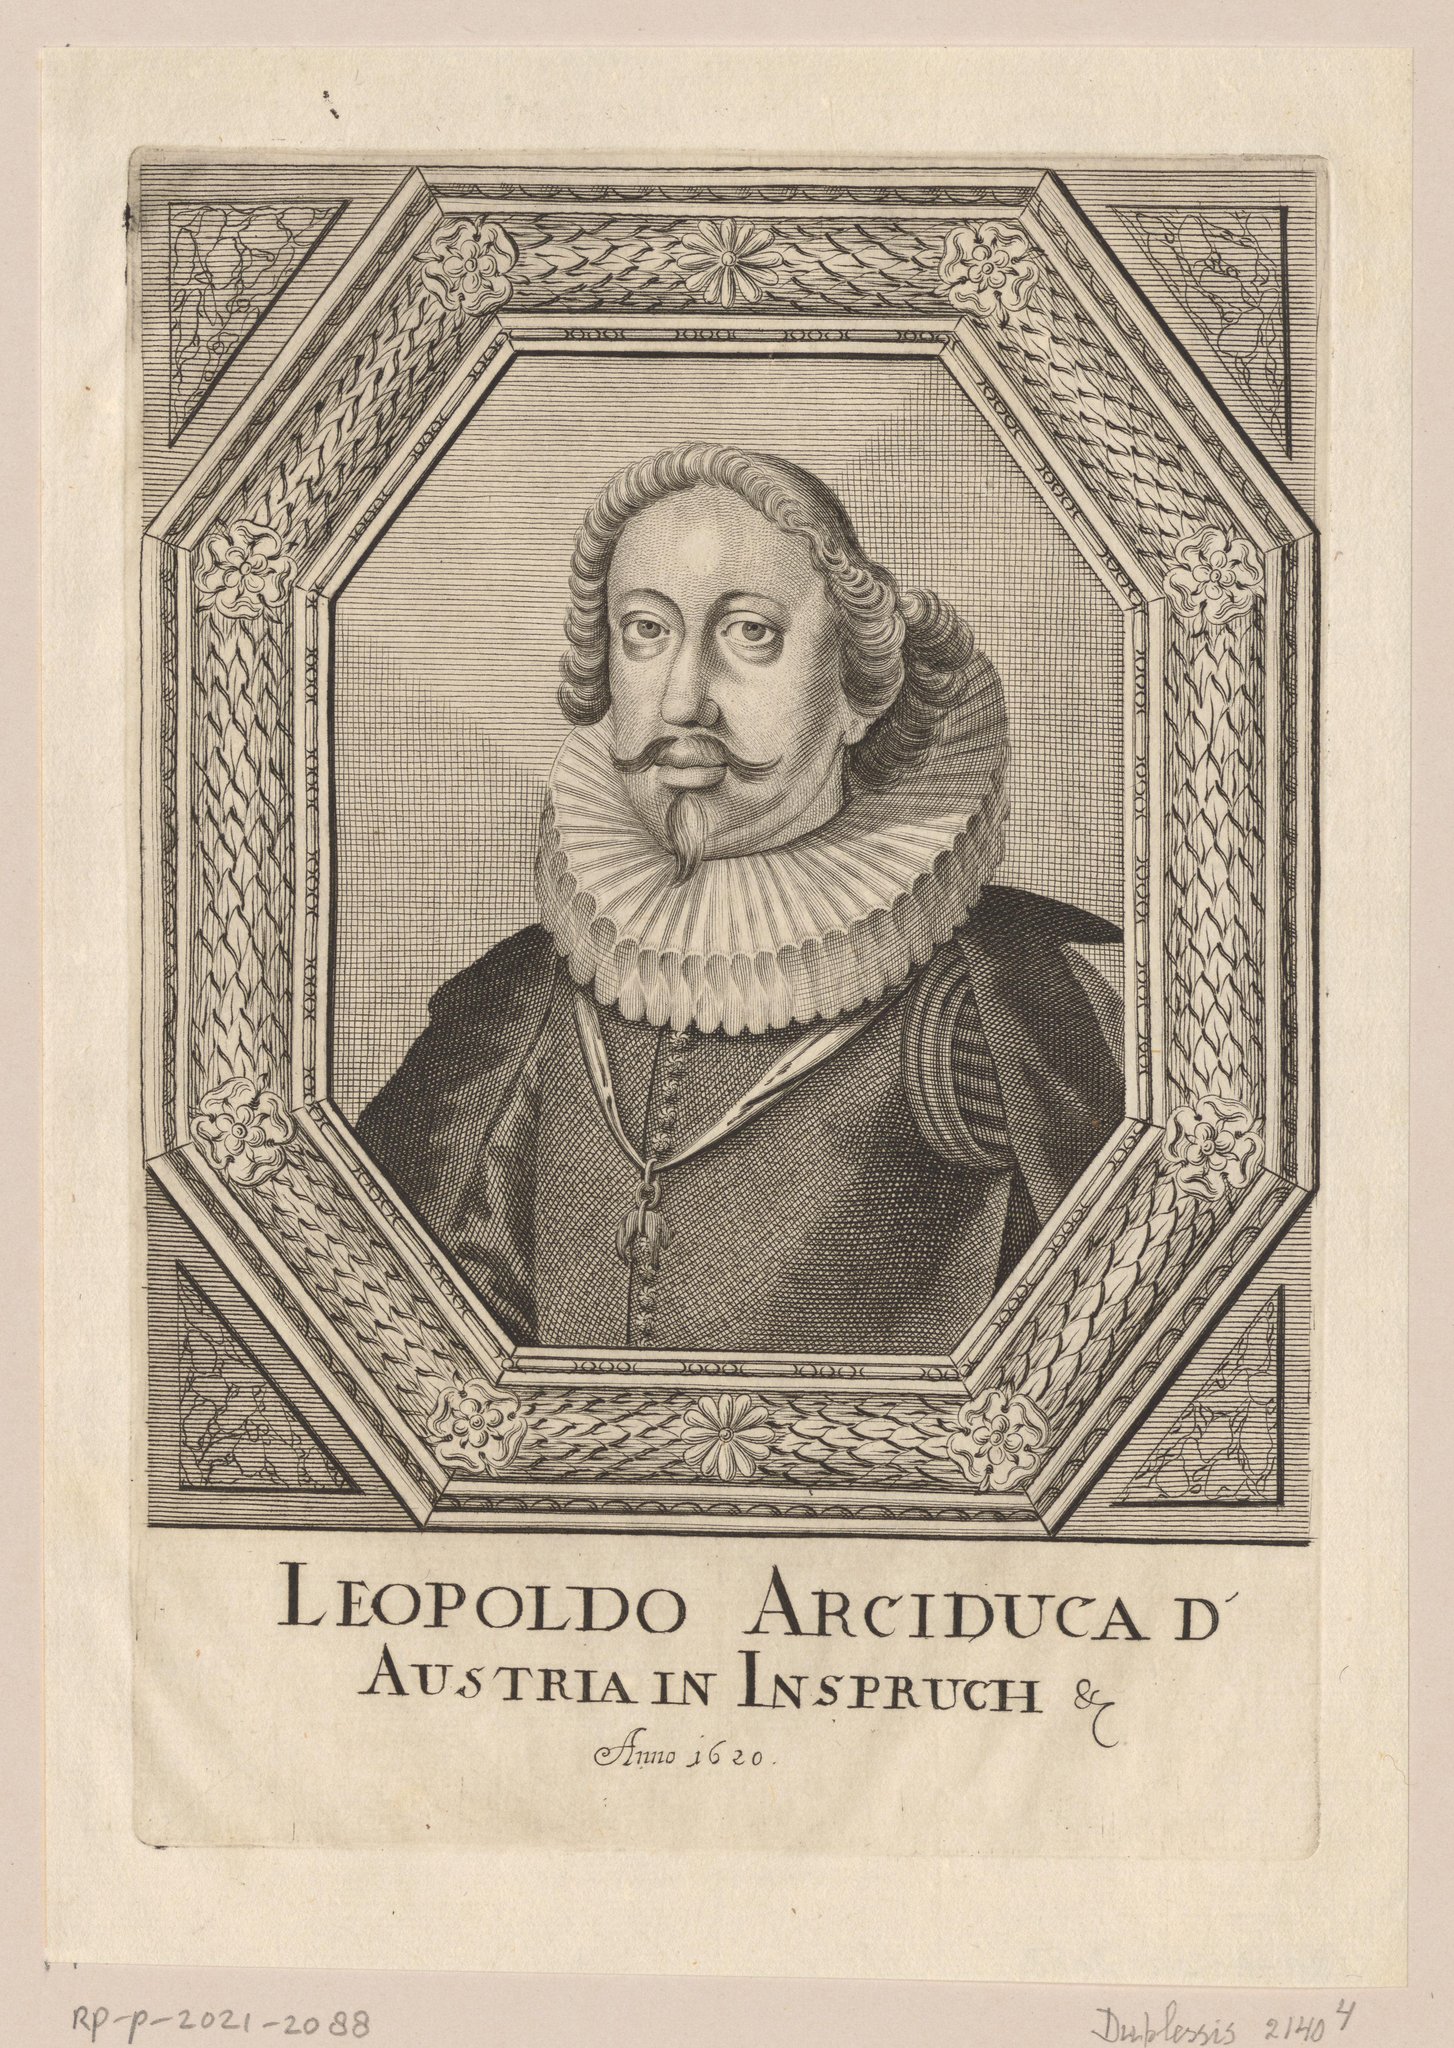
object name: print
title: Portret van Leopold V, aartshertog van Oostenrijk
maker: Anonymous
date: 1620-1699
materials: paper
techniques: engraving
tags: leopold v (aartshertog van oostenrijk), historical persons, knighthood order of the golden fleece - insignia of a knighthood order, e.g.: badge, chain (with name of order)